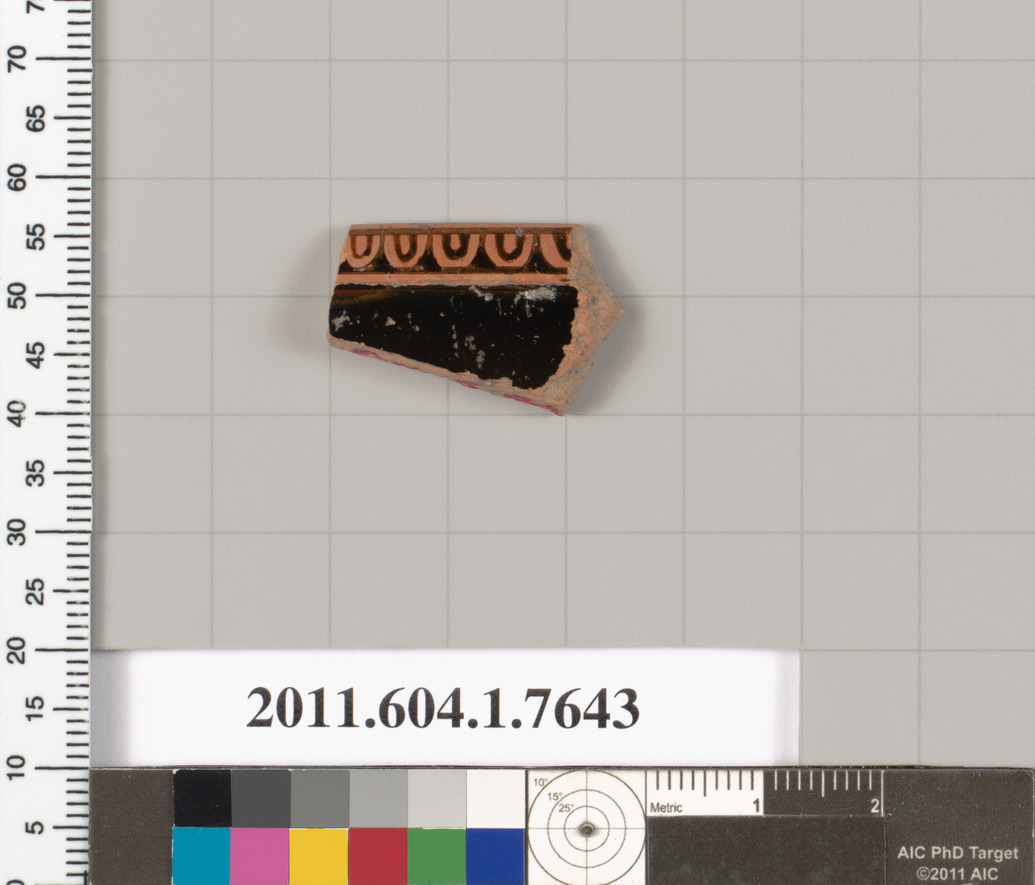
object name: kylix fragment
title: Terracotta fragment of a kylix (drinking cup)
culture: greek, attic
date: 460-450 BCE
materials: terracotta